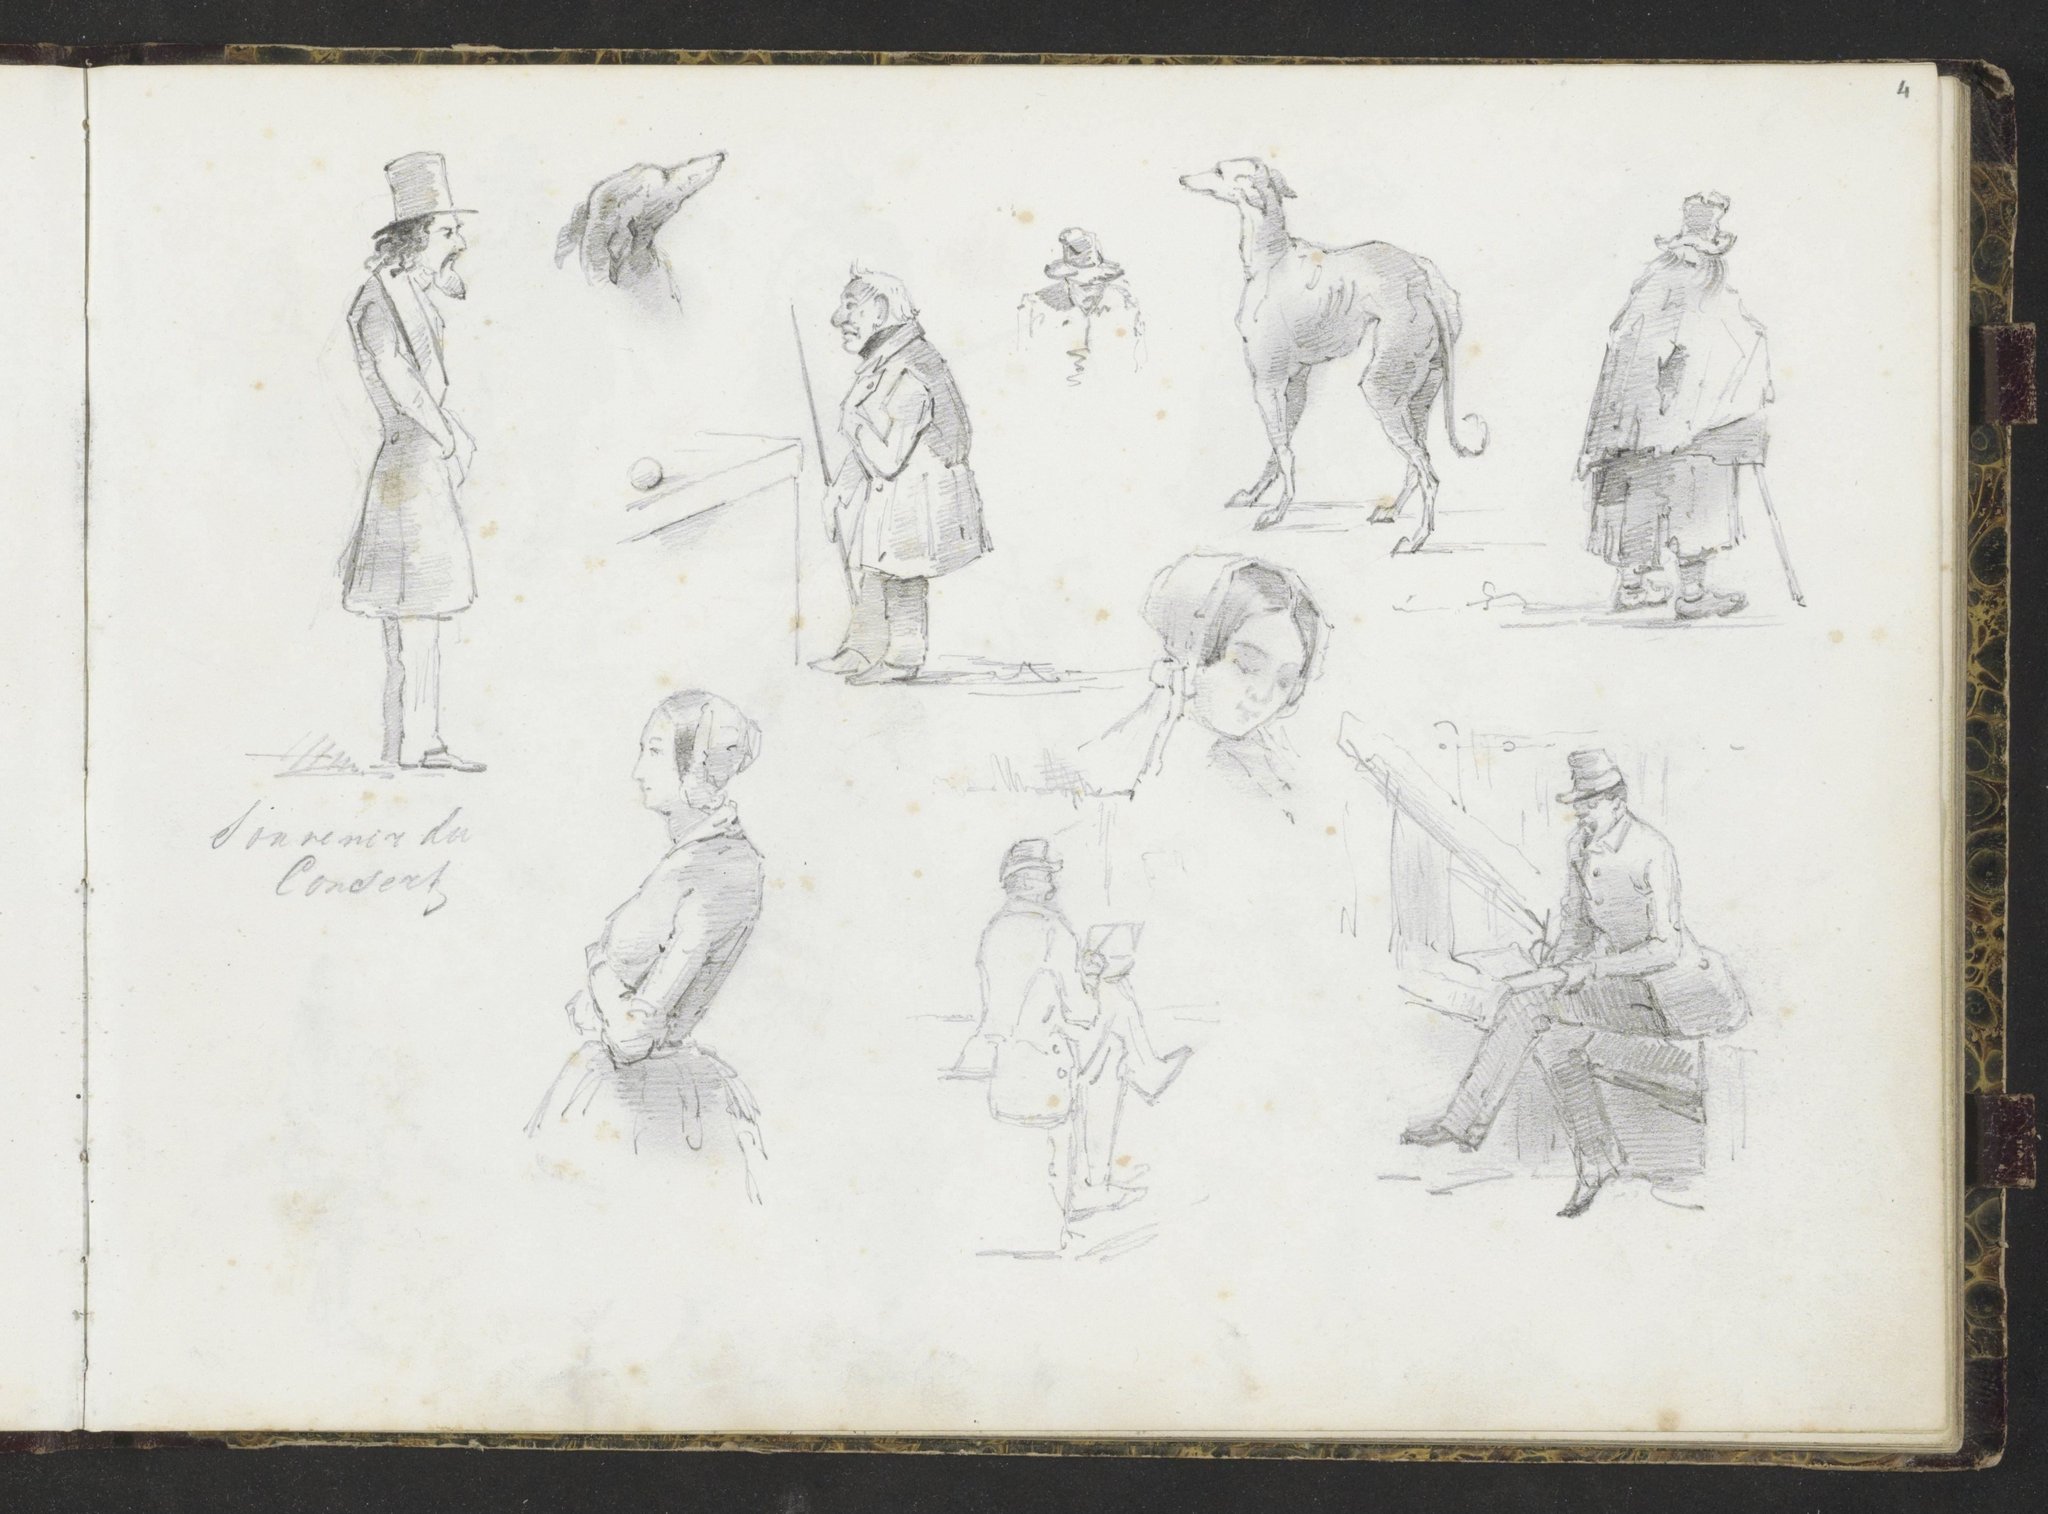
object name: sketchbook leaf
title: Studieblad met figuren en honden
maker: lambertus lingeman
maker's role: draughtsman, painter, print maker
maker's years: 1829-1894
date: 1839-1894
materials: paper, pencil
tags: anatomy (non-medical), billiards (+ sportsman, player, etc.), dog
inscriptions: annotation: ‘Souvenir du/ Consert’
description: Onder andere studies van twee vrouwen met kappen, een tekenende en/of schrijvende figuur, een man in een versleten mantel met een wandelstok en een biljartspeler. Blad 4 recto uit een schetsboek met 51 bladen.